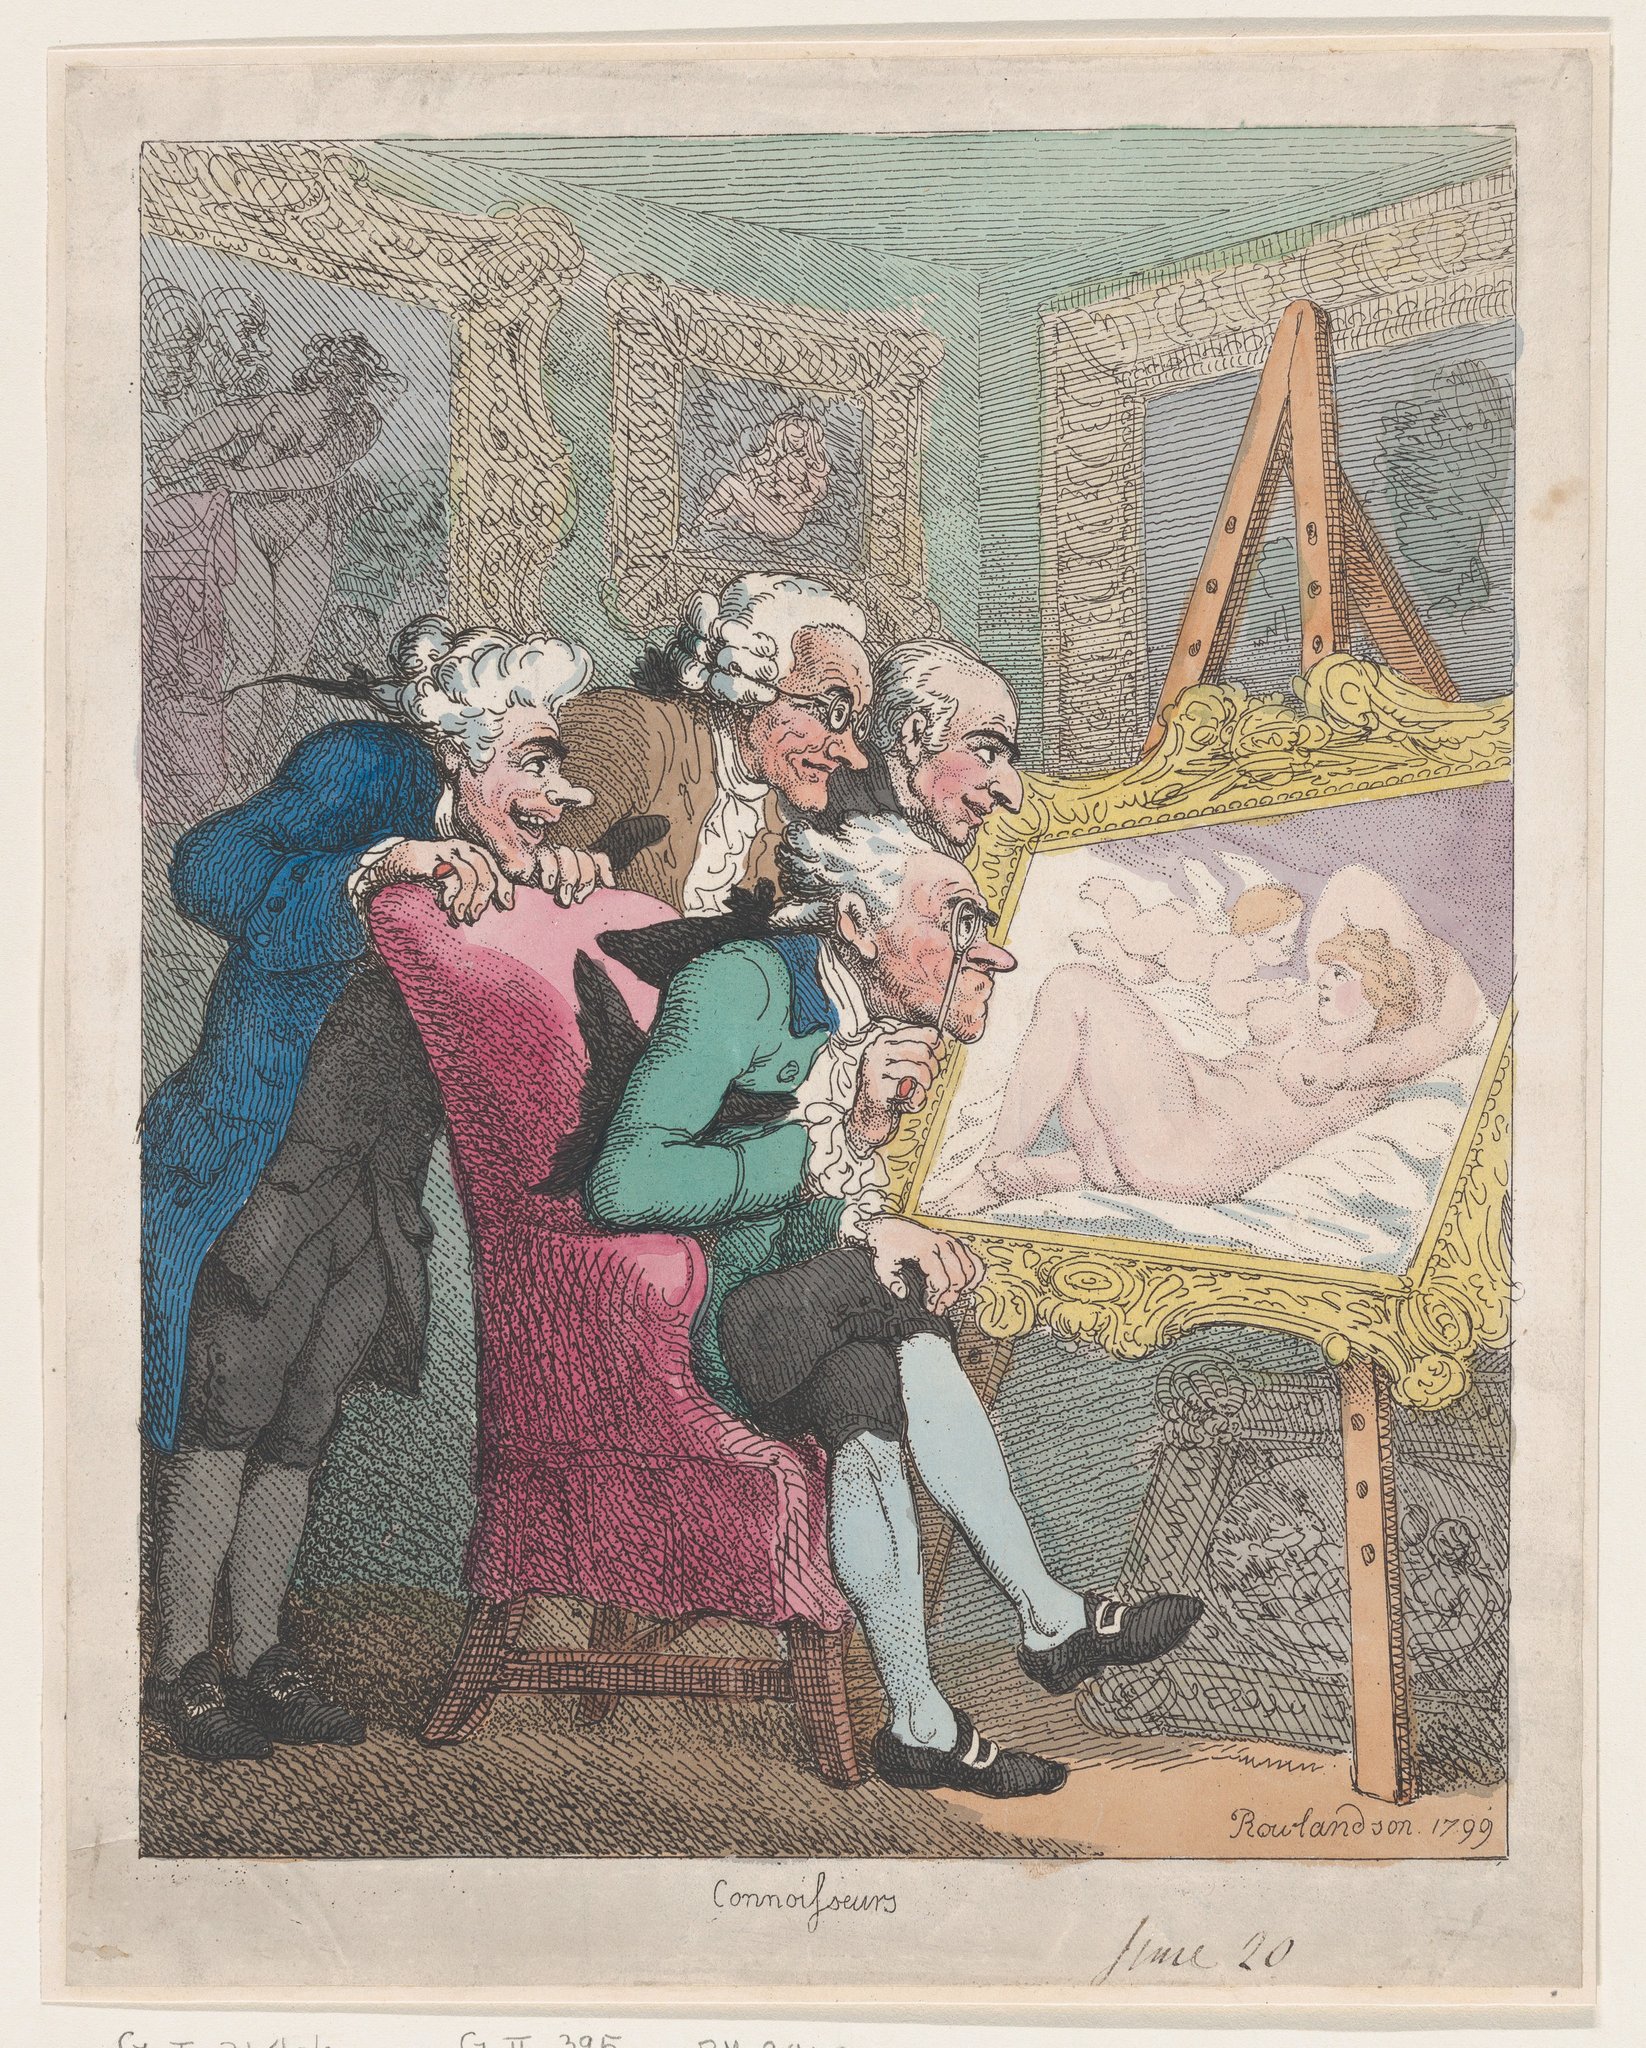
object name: print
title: Connoisseurs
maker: thomas rowlandson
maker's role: artist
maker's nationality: british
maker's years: 1757-1827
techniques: etching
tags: men,cupid,venus